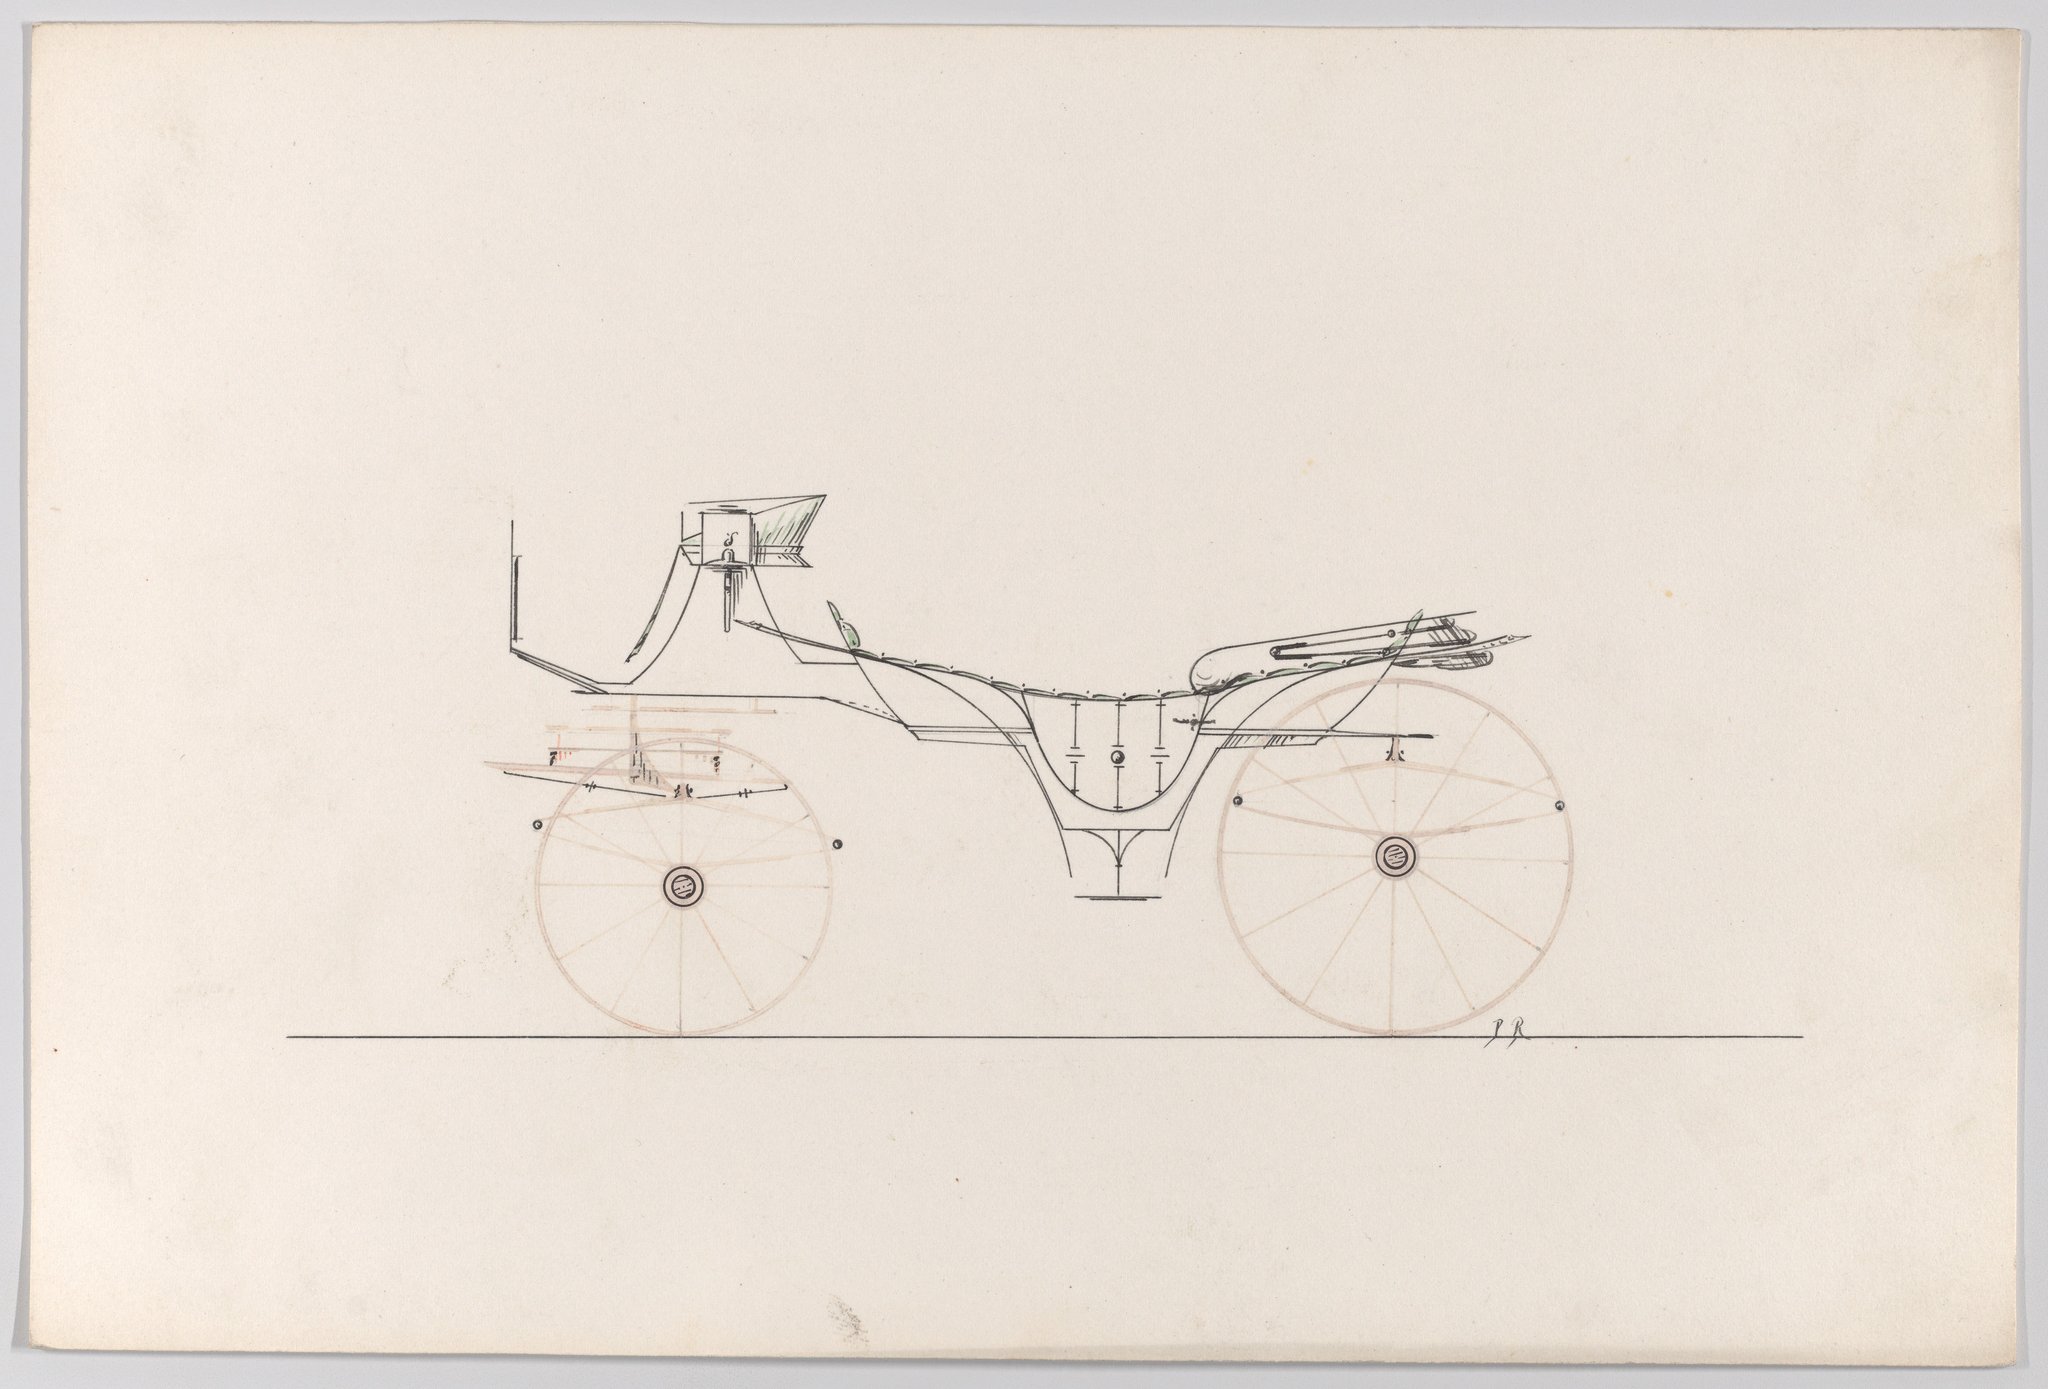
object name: drawing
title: Design for Vis-à-vis/ Calèche (unnumbered)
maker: brewster & co.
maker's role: manufacturer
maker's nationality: american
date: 1865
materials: gouache, ink, watercolor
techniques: pen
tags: carriages